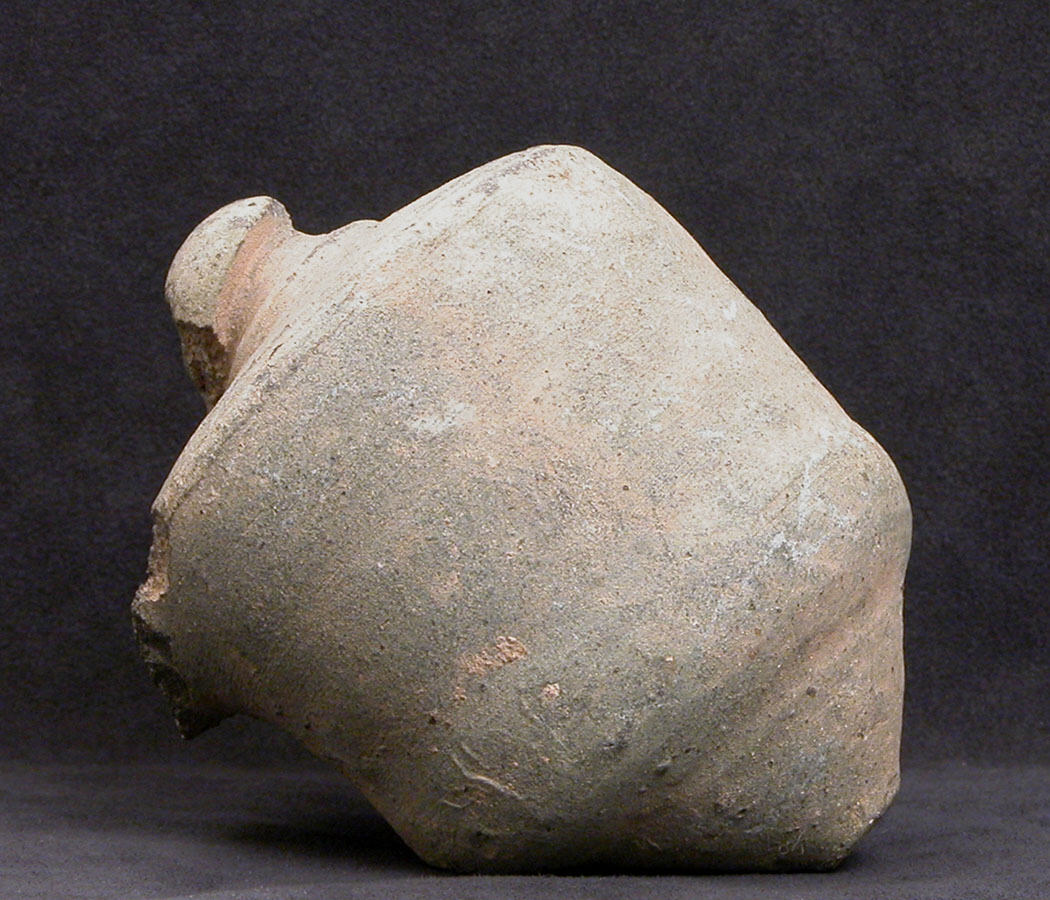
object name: vessel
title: Spheroconical Vessel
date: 801-1000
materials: earthenware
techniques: incising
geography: iran